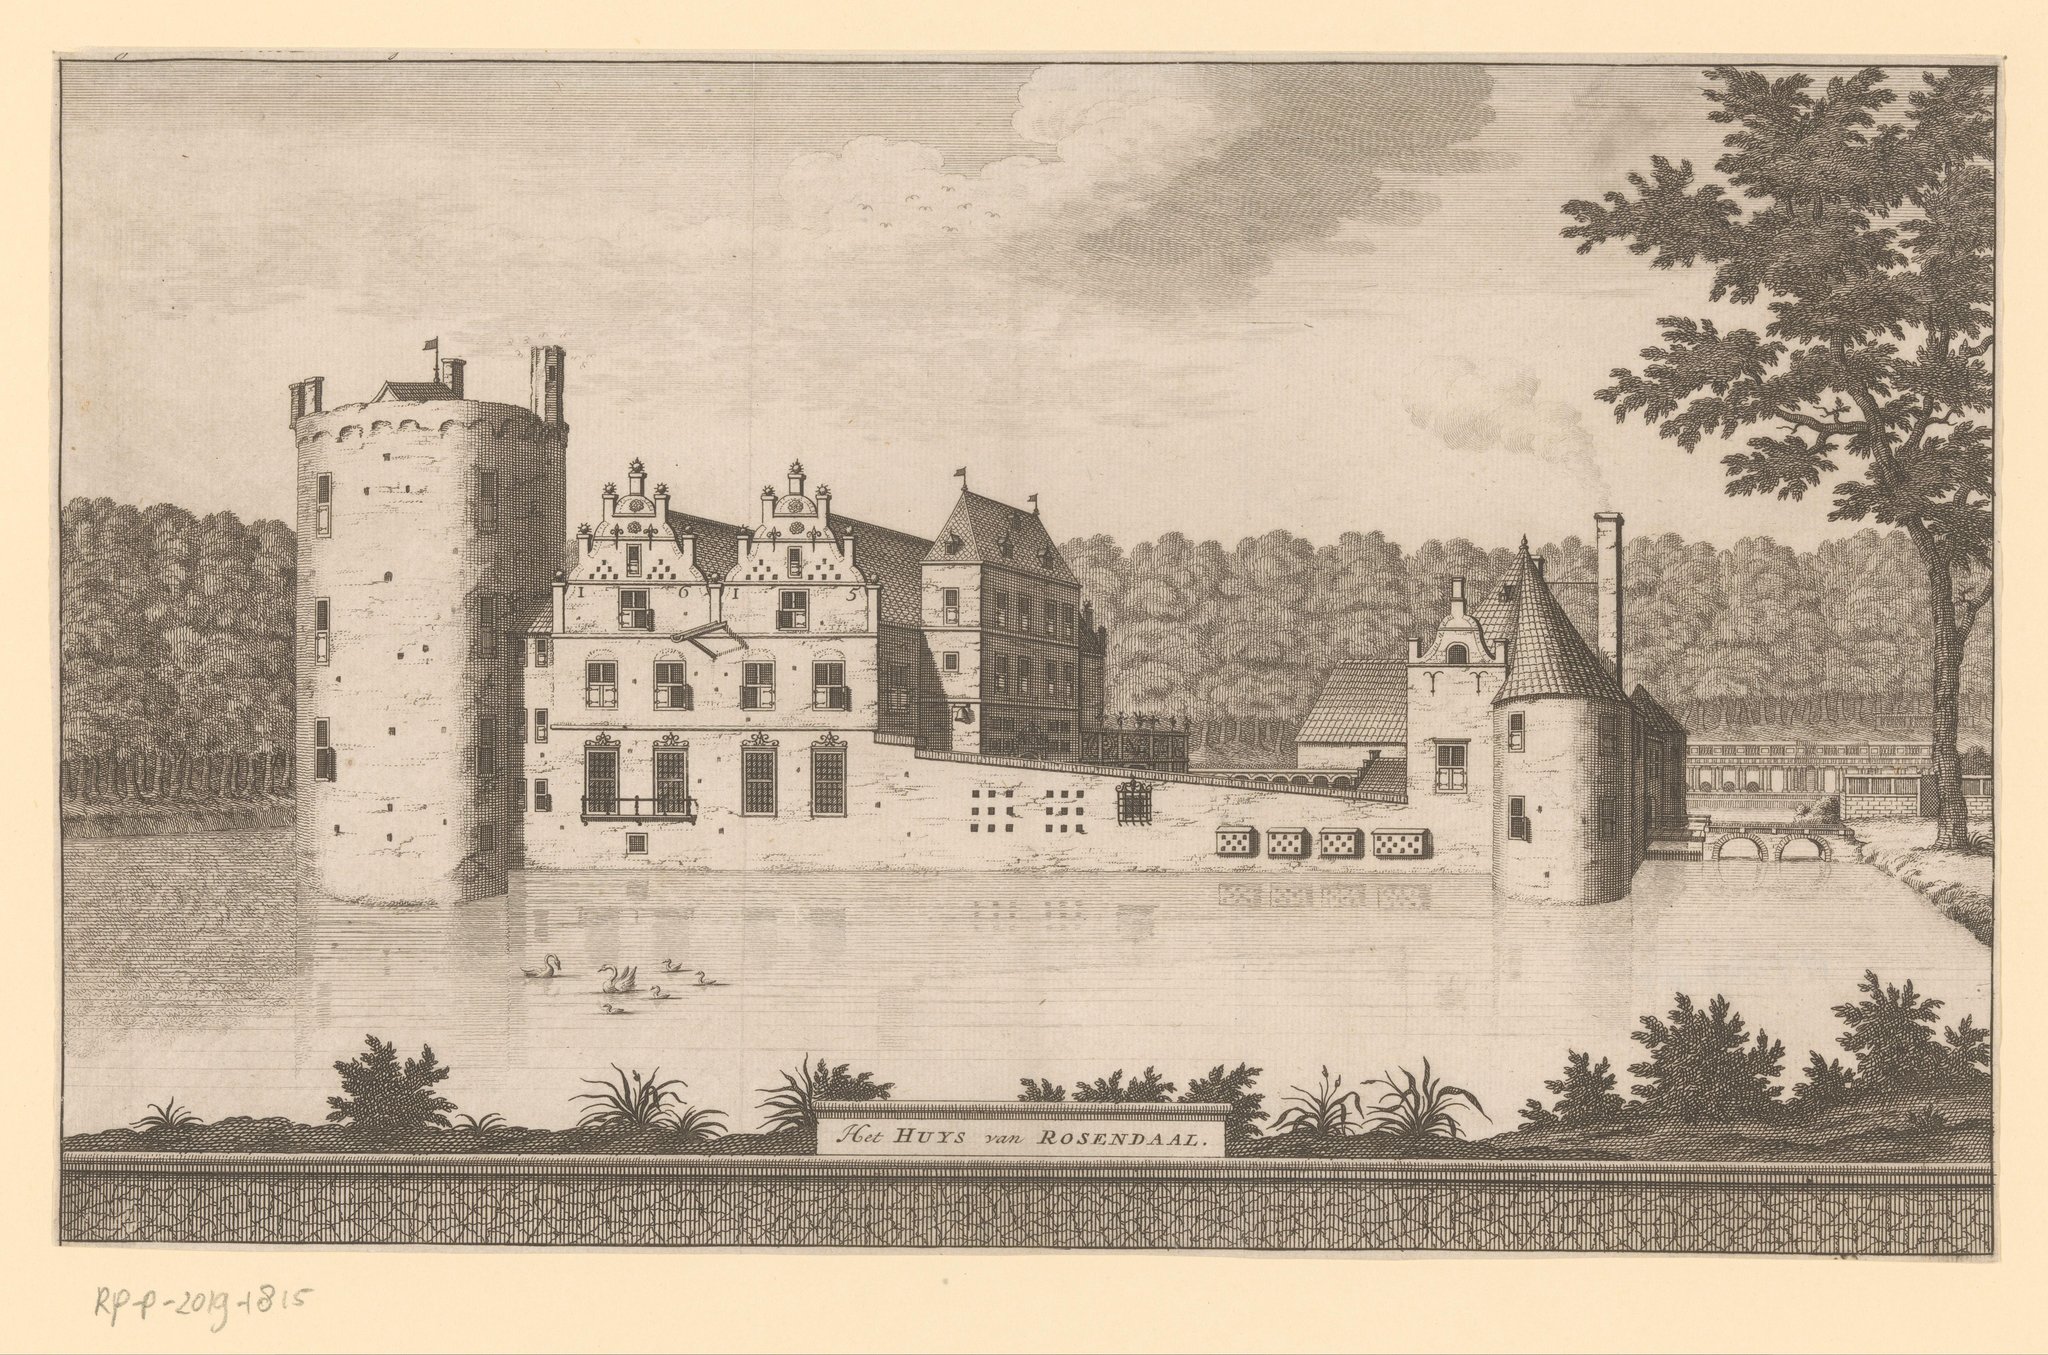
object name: print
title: Gezicht op Kasteel Rosendael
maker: Anonymous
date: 1730-1770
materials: paper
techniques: etching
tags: the hague, jan van arnhem, castle, landscape with tower or castle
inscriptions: inscription: ‘In 1716 behorende aan Joan B. van Arnhem Heere van Rosendael tot [...] . Hij [...] het meeste aan.’